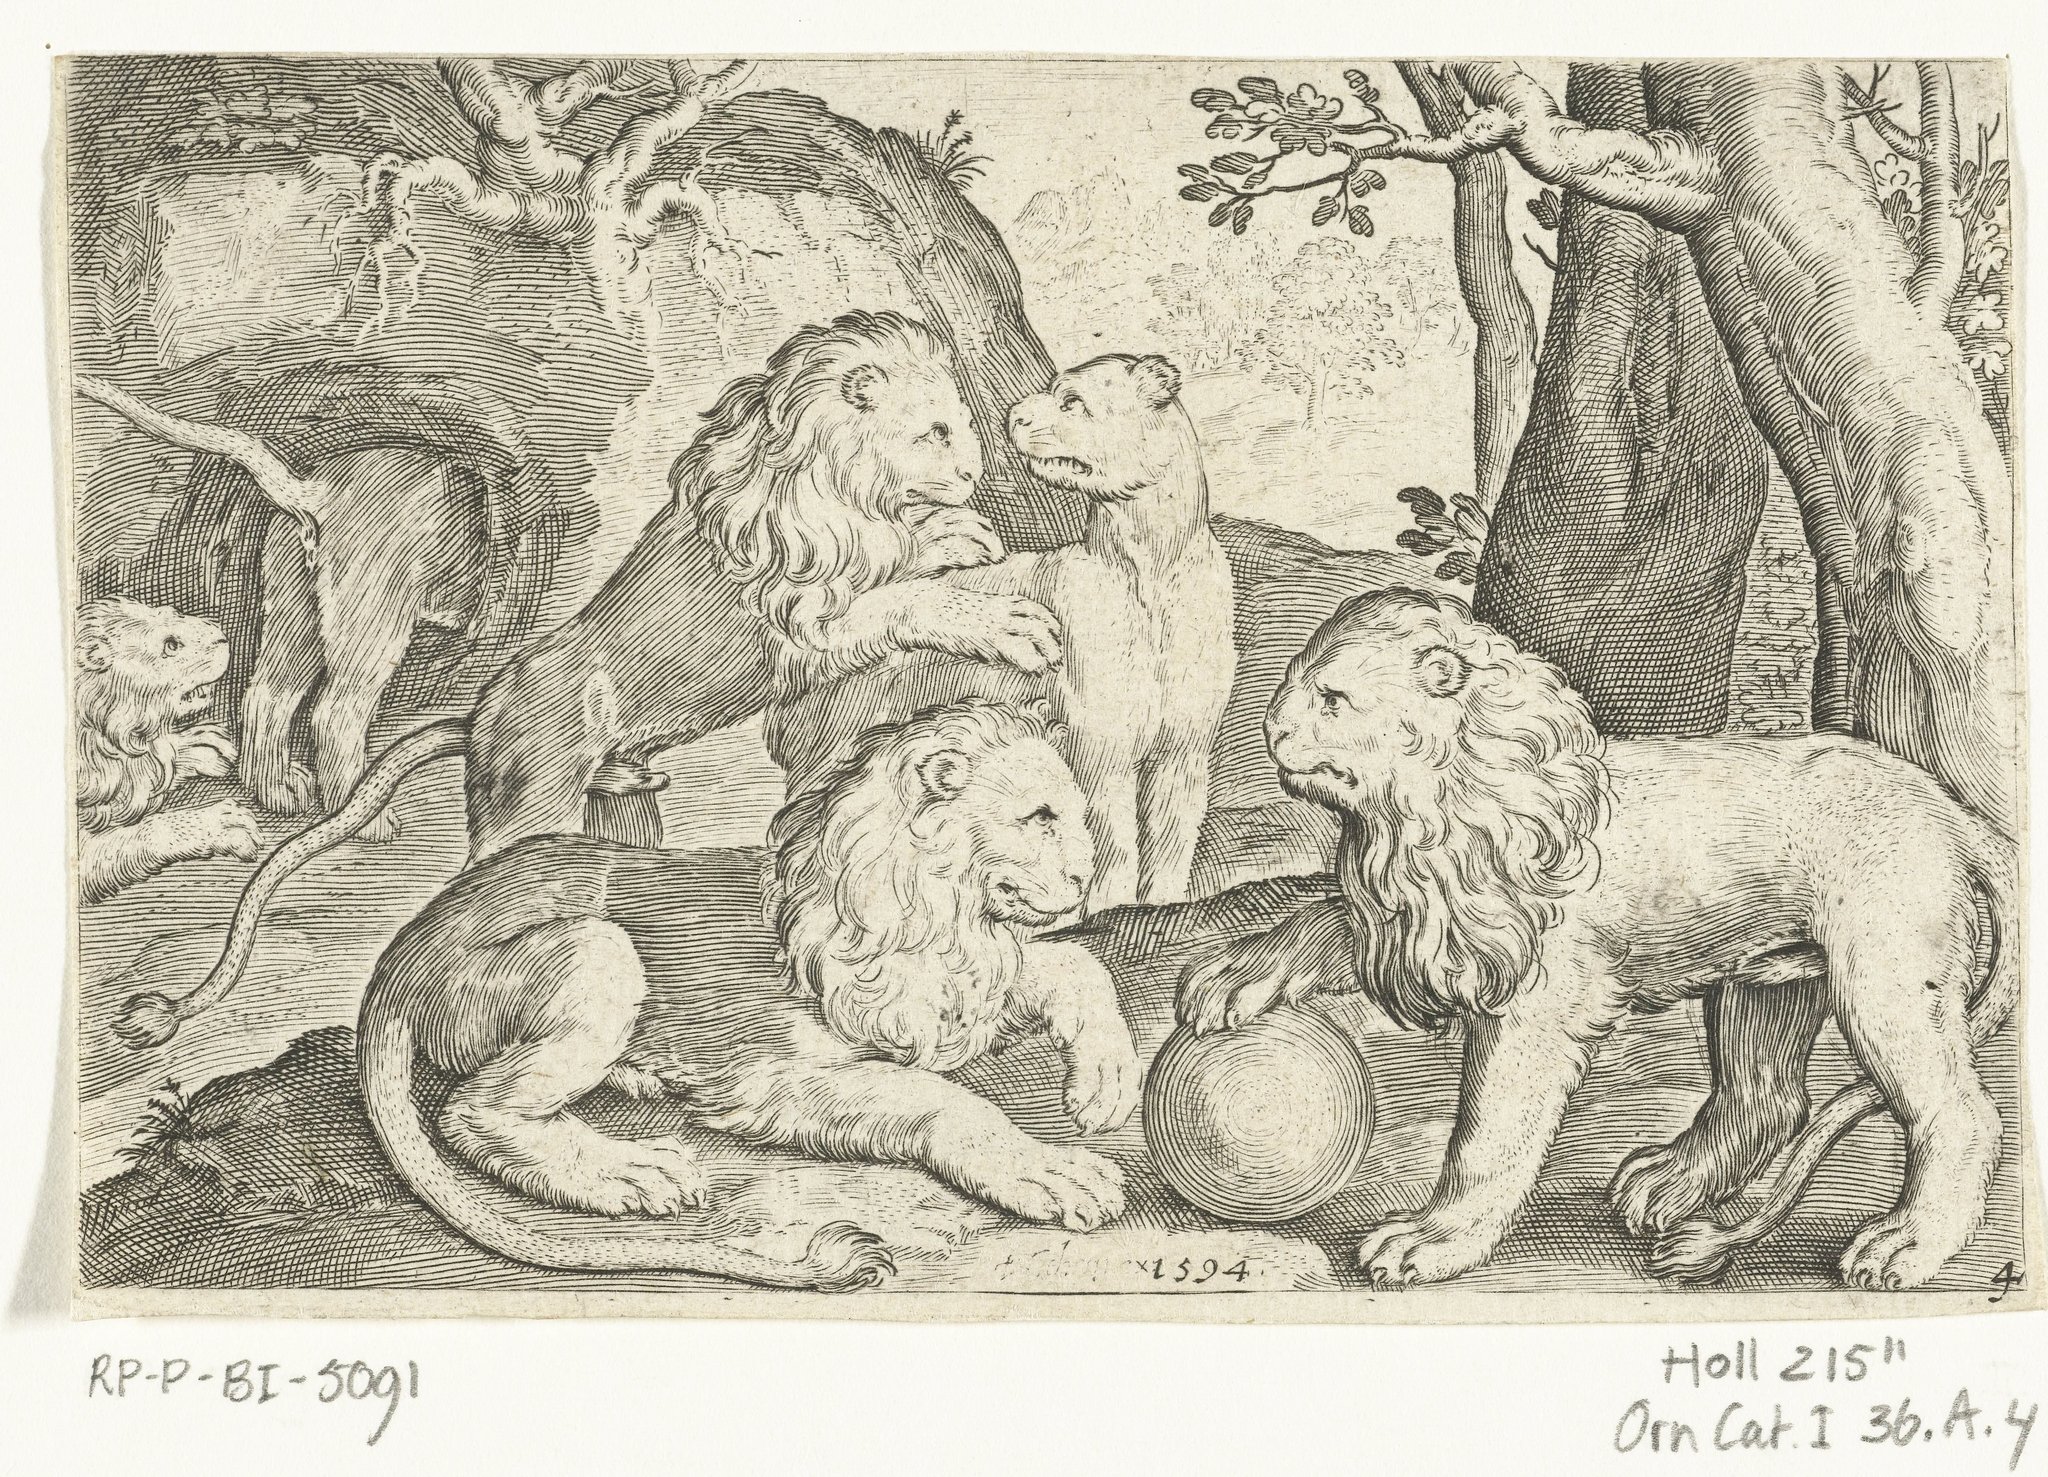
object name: print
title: Leeuwen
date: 1594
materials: paper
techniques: engraving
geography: amsterdam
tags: beasts of prey, predatory animals: lion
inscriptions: collector's mark: Lugt 2228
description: Prent uit serie Animalivm qvadrvpedvm van twaalf prenten met dieren (viervoeters) in landschappen. Hollstein beschrijft twee staten, als eerste staat een uitgave van Assuerus van Londerseel voor de nummering (gedateerd 1594) en als tweede staat een uitgave van Claes Jansz. Visscher (II) met nummering (gedateerd 1621). Er is echter nog een andere editie bekend van uitgever Christoffel van Sichem welke tussen deze twee staten in geplaatst kan worden. Verschillende drukken van Visscher vertonen nog sporen van een adres van Van Sichem, op een enkel blad in de collectie van het RMA staat zijn adres, vergelijk RP-P-OB-16.158. De editie van Visscher is gedrukt van zeer versleten platen, zie De Groot 1988, p. 36, 37.